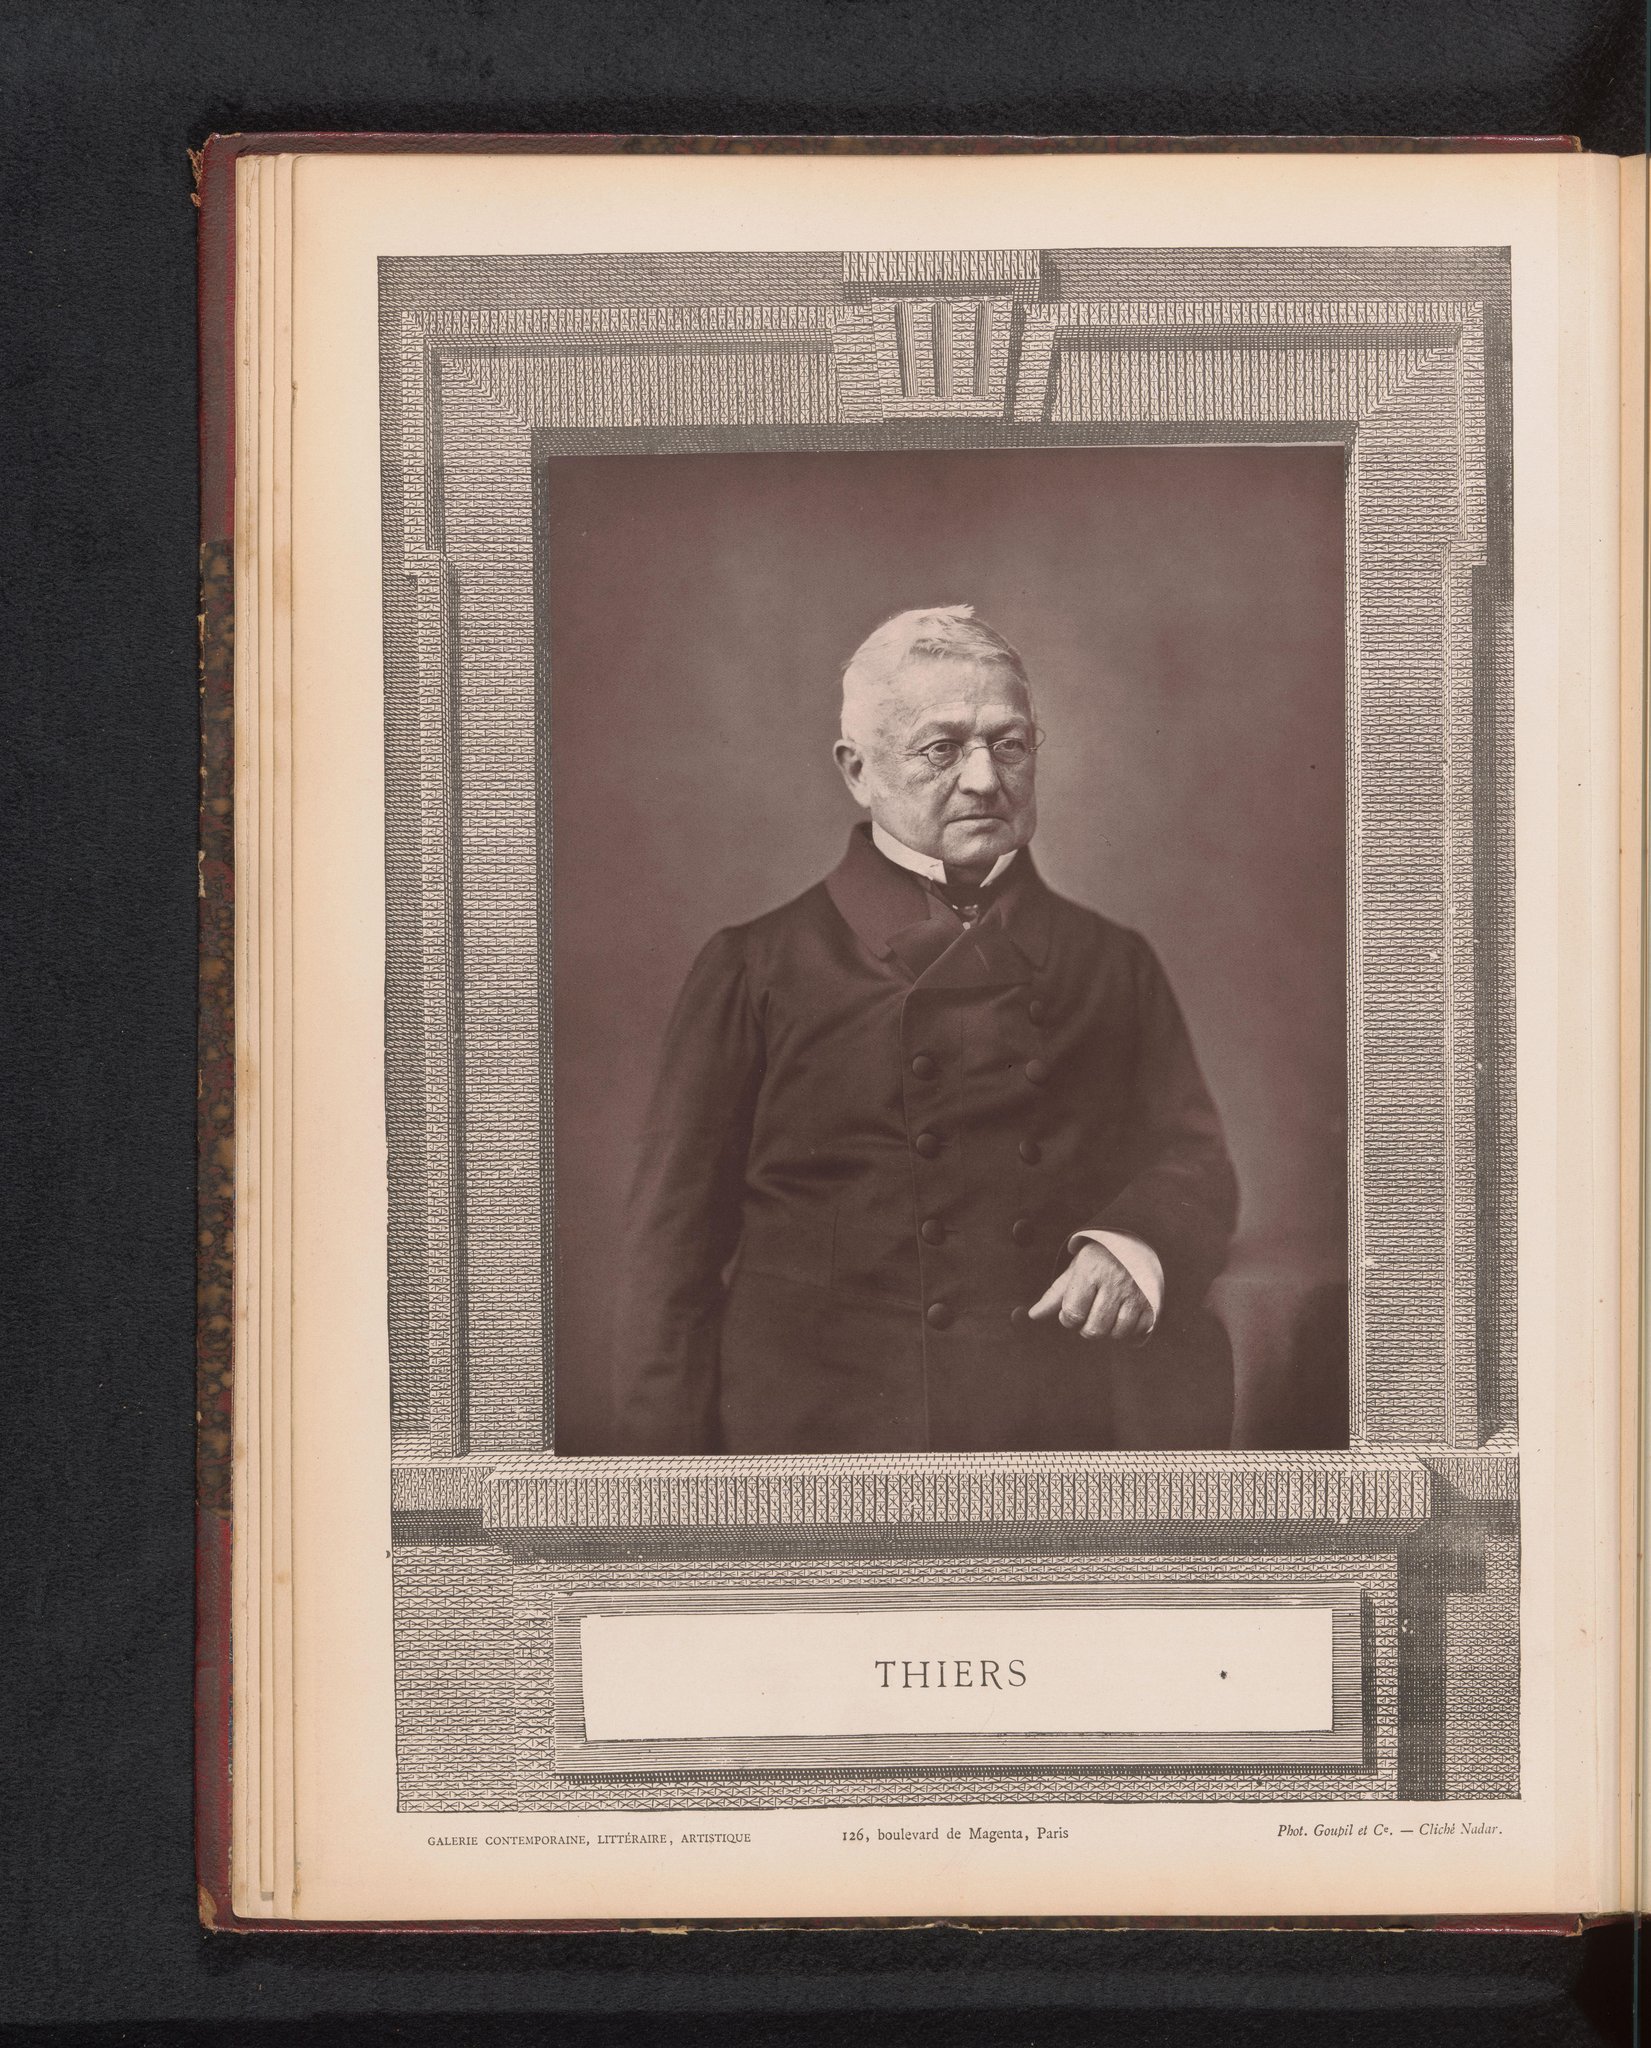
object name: photomechanical print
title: A. Thiers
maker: félix nadar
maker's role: ballonvaarder, fotograaf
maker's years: 1820-1910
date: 1871-1876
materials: paper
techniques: woodburytype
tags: politician, adult man, historical persons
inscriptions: inscription: ‘Galerie Contemporaine, Littéraire, Artistique/ 126, boulevard de Magenta, Paris’